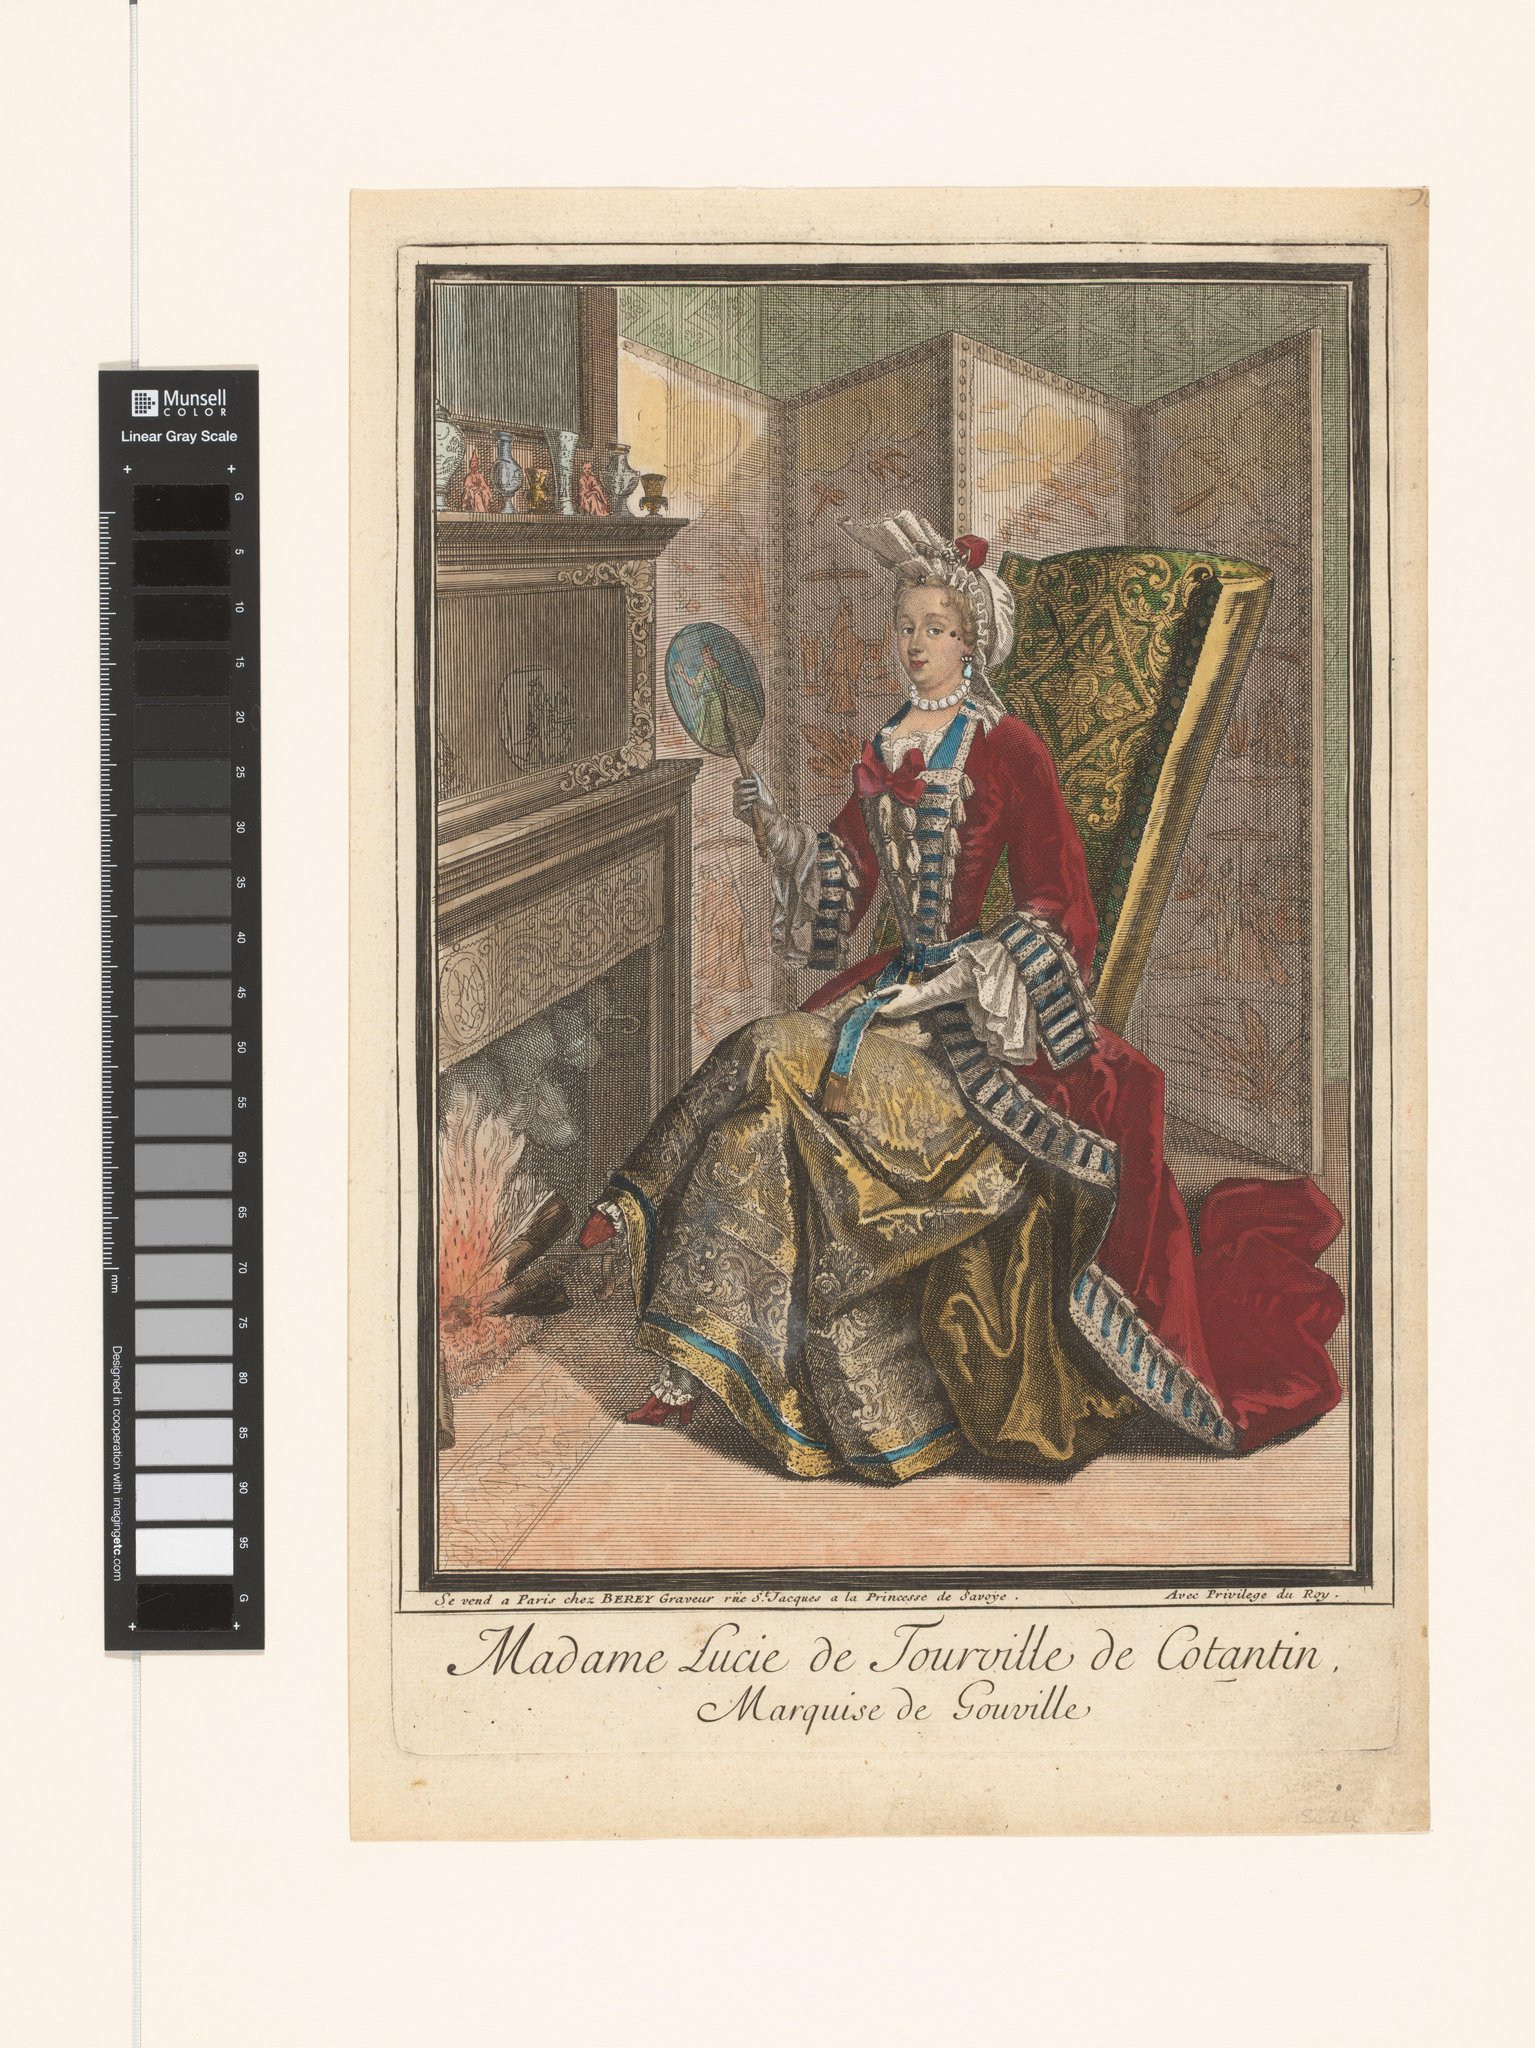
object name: fashion print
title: Madame Lucie de Tourville de Cotantin, Marquise de Gouville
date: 1690-1695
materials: paper, ink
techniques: etching, hand coloring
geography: france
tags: armchair, seat, skirt (underskirt) (+ women's clothes), open hearth, fire-place, fashion plates, dress, gown (+ women's clothes), head-gear: fontange (+ women's clothes), clothing for the upper part of the body (with name) (+ women's clothes), pearl; pearl necklace (+ women's clothes)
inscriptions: address: ‘Se vend à Paris chez Berey rue de St. Jacques à la Pricesse de Savoye.’, title: ‘Madame Lucie de Tourville de Cotantin, Marquise de Gouville’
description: Madame Lucie de Tourville de Cotantin zittend bij de open haard, een vuurscherm in de hand. Rood overkleed over een goudkleruig onderkleed. Fontangekapsel met - muts. Achter haar een kamerscherm.